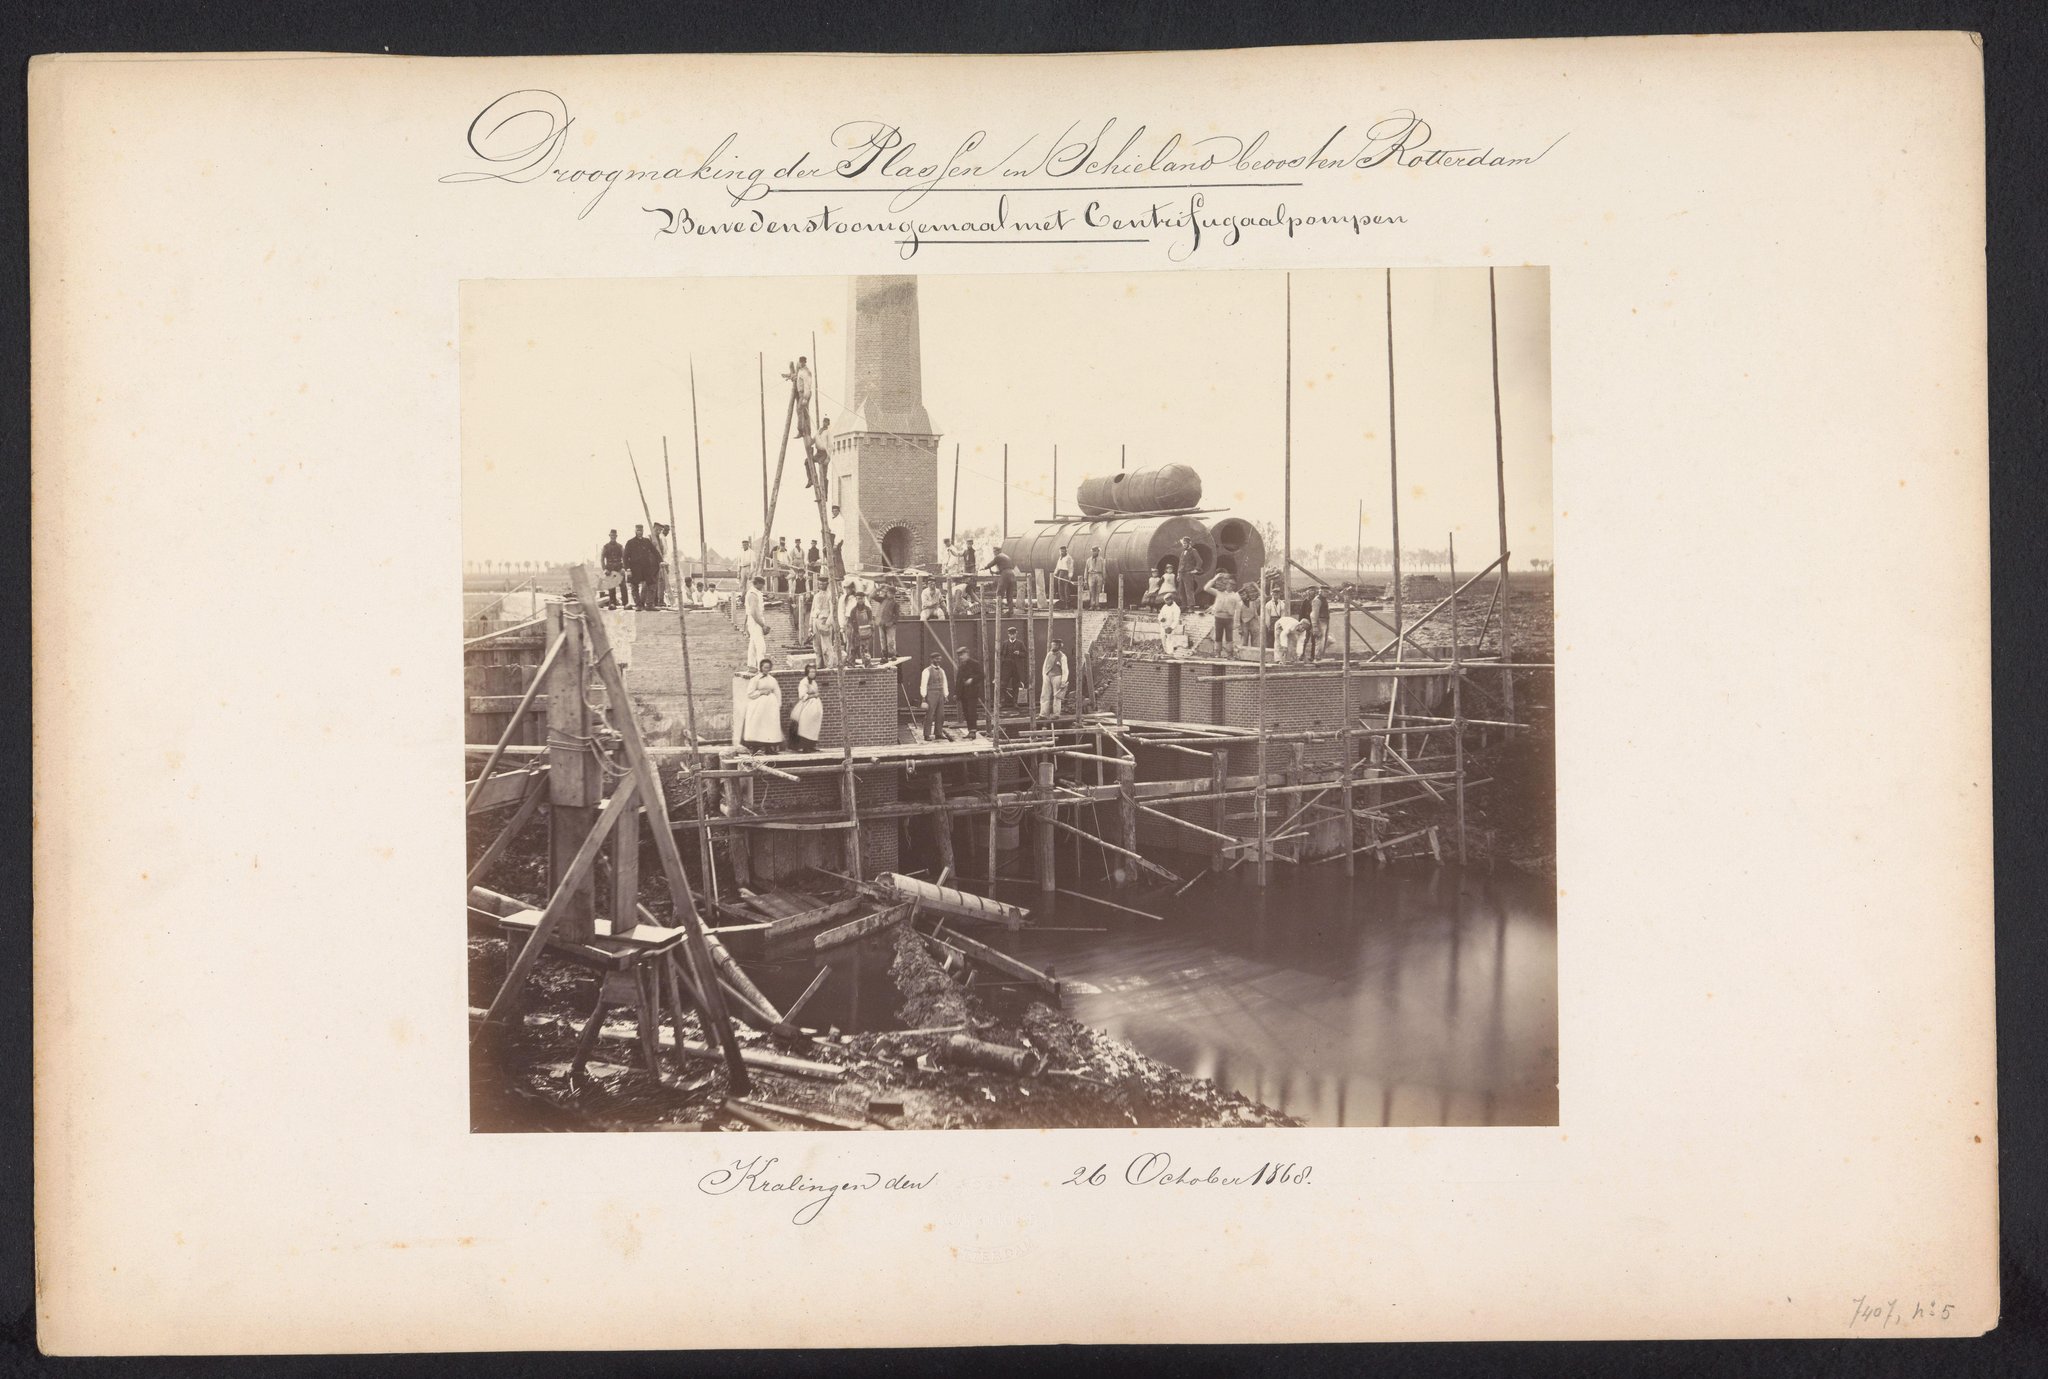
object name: photograph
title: Droogmaking der Plassen in Schieland beoosten Rotterdam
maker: jacobus van gorkom (jr.)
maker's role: print maker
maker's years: 1827-1880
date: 1868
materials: cardboard, photographic support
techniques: albumen print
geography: rotterdam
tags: draining for land reclamation, pumping installation, pumping-engine (~ polder)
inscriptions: date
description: Stoomgemaal te Kralingen op 26 oktober 1868. Onderdeel van een serie van tien foto's van de droogmaking in 1867-1869 van de plassen in Schieland ten oosten van Rotterdam.